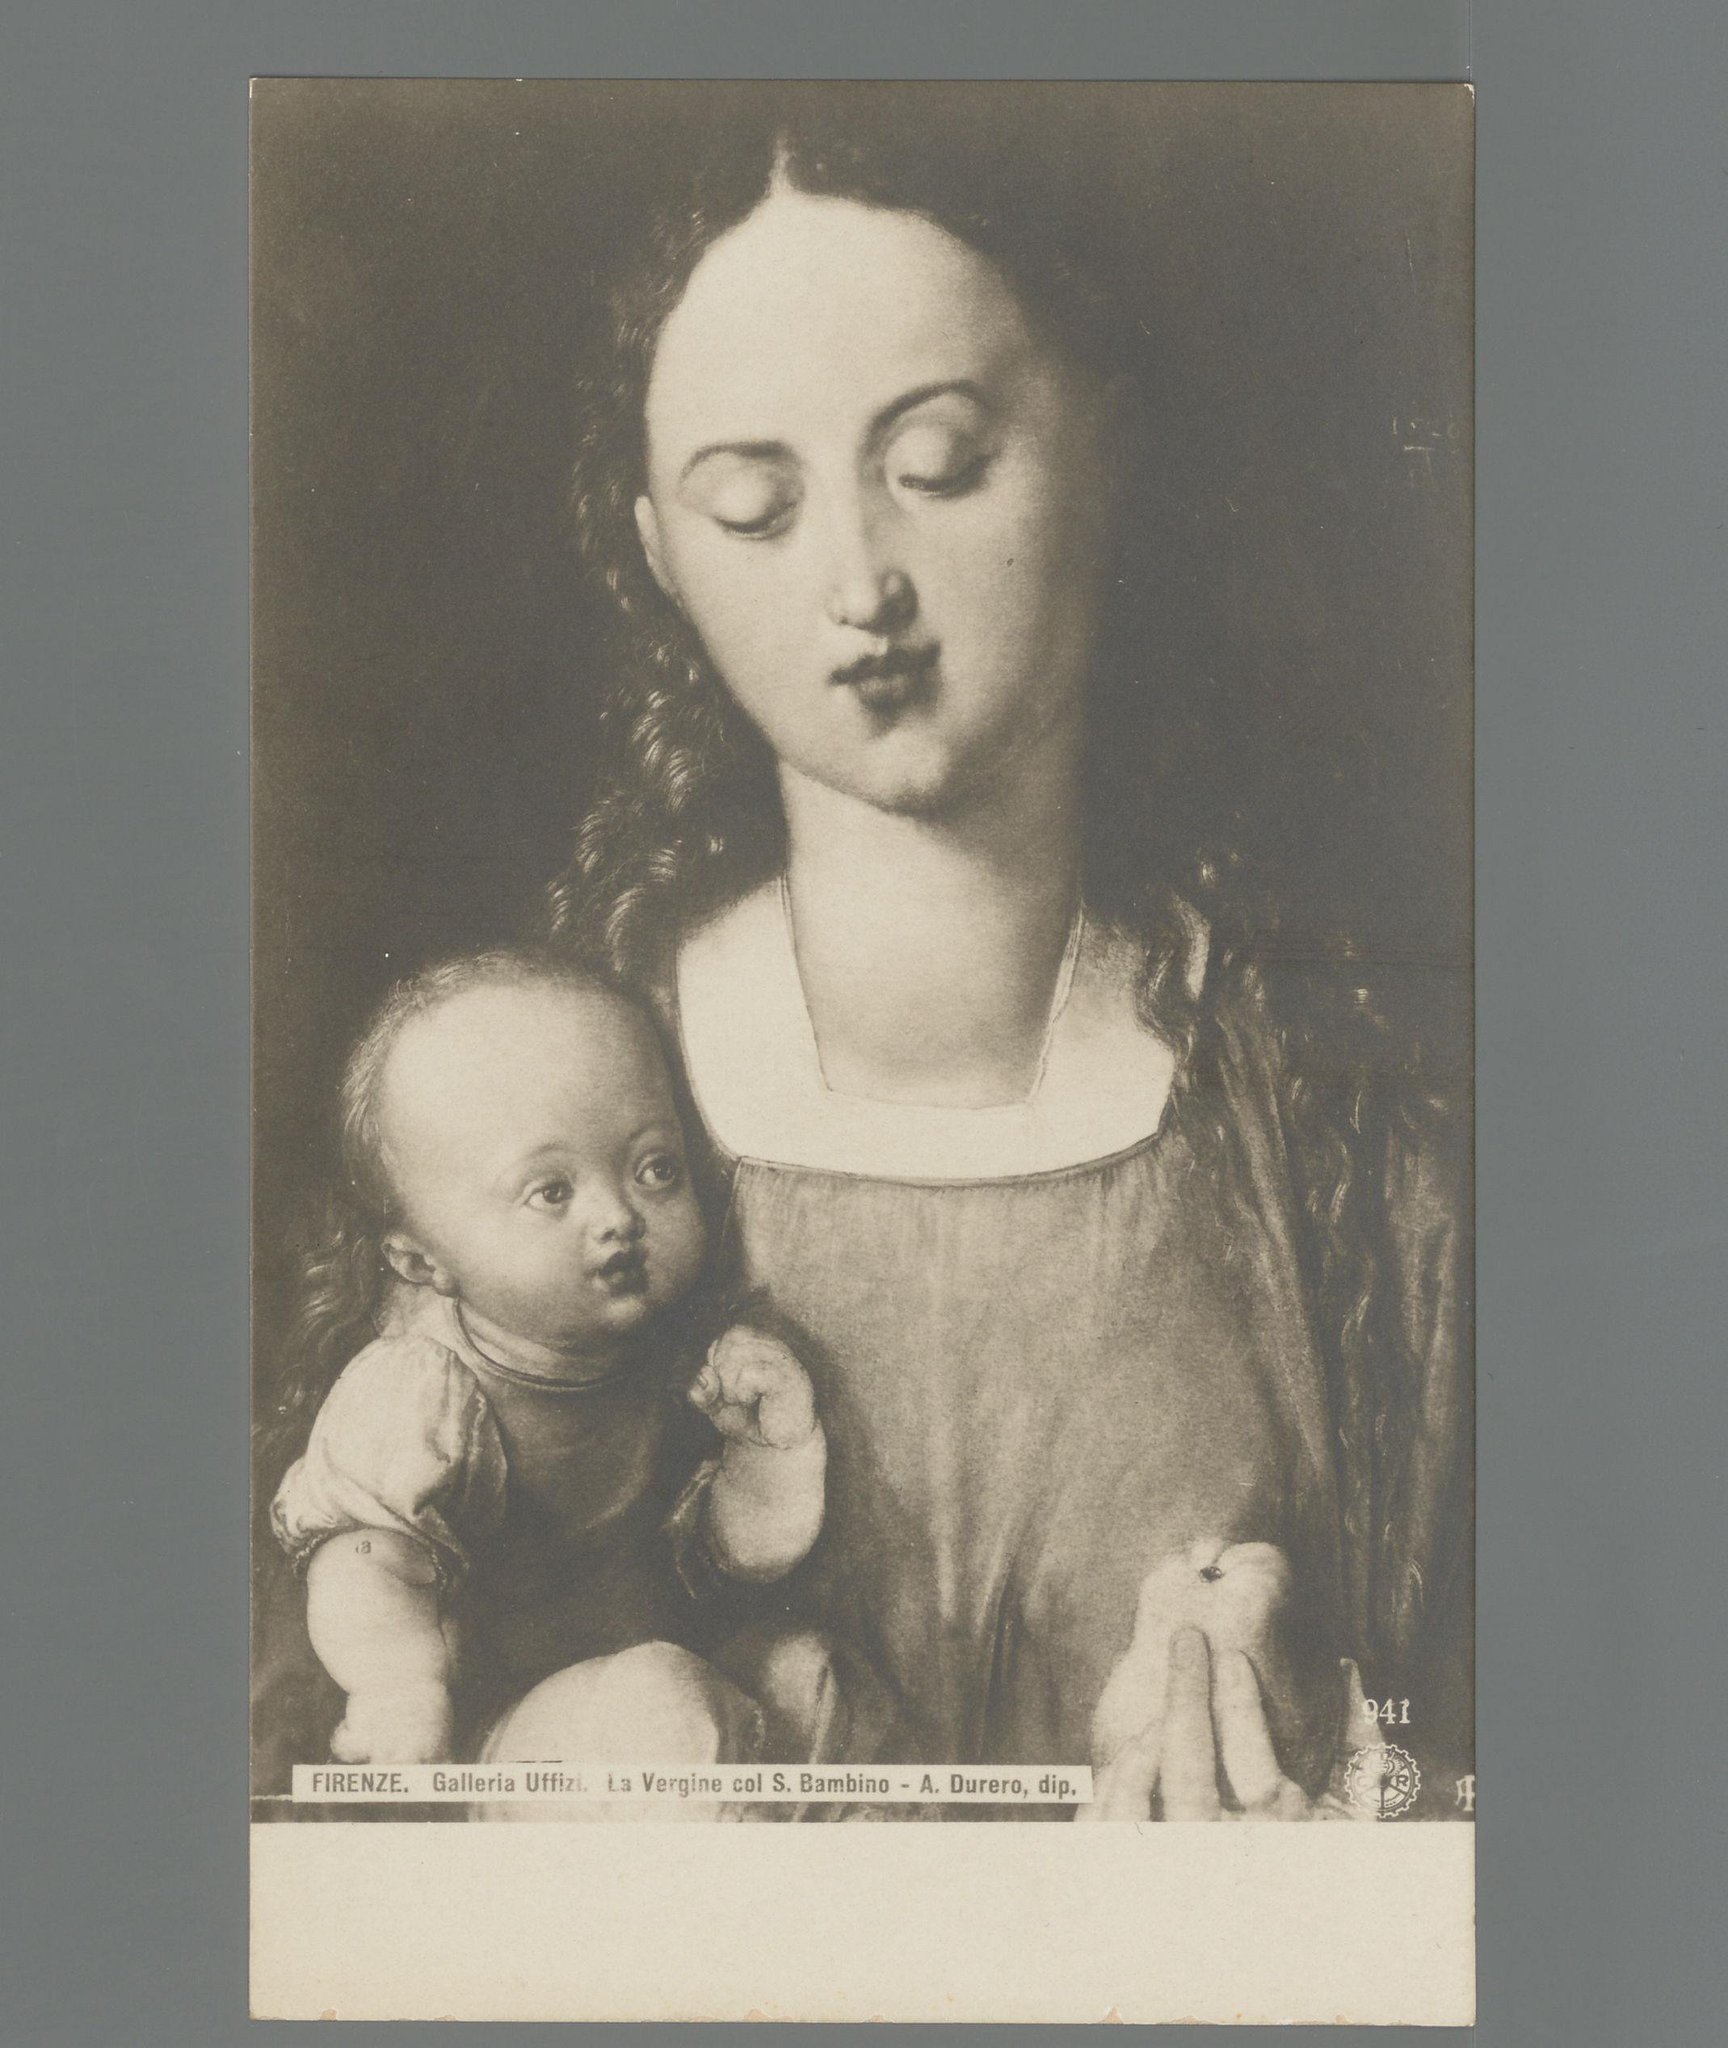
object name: photograph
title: Firenze - Galleria Uffizi. La Vergine col S. Bambino - A. Durero, dip.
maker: carlo brogi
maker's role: fotograaf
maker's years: 1850-1925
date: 1905-1925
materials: paper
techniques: gelatin silver print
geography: florence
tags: permanent exhibition, museum, picture, painting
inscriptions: monogram: ‘RI’, monogram, collector's mark: ‘AFE v S’, monogram